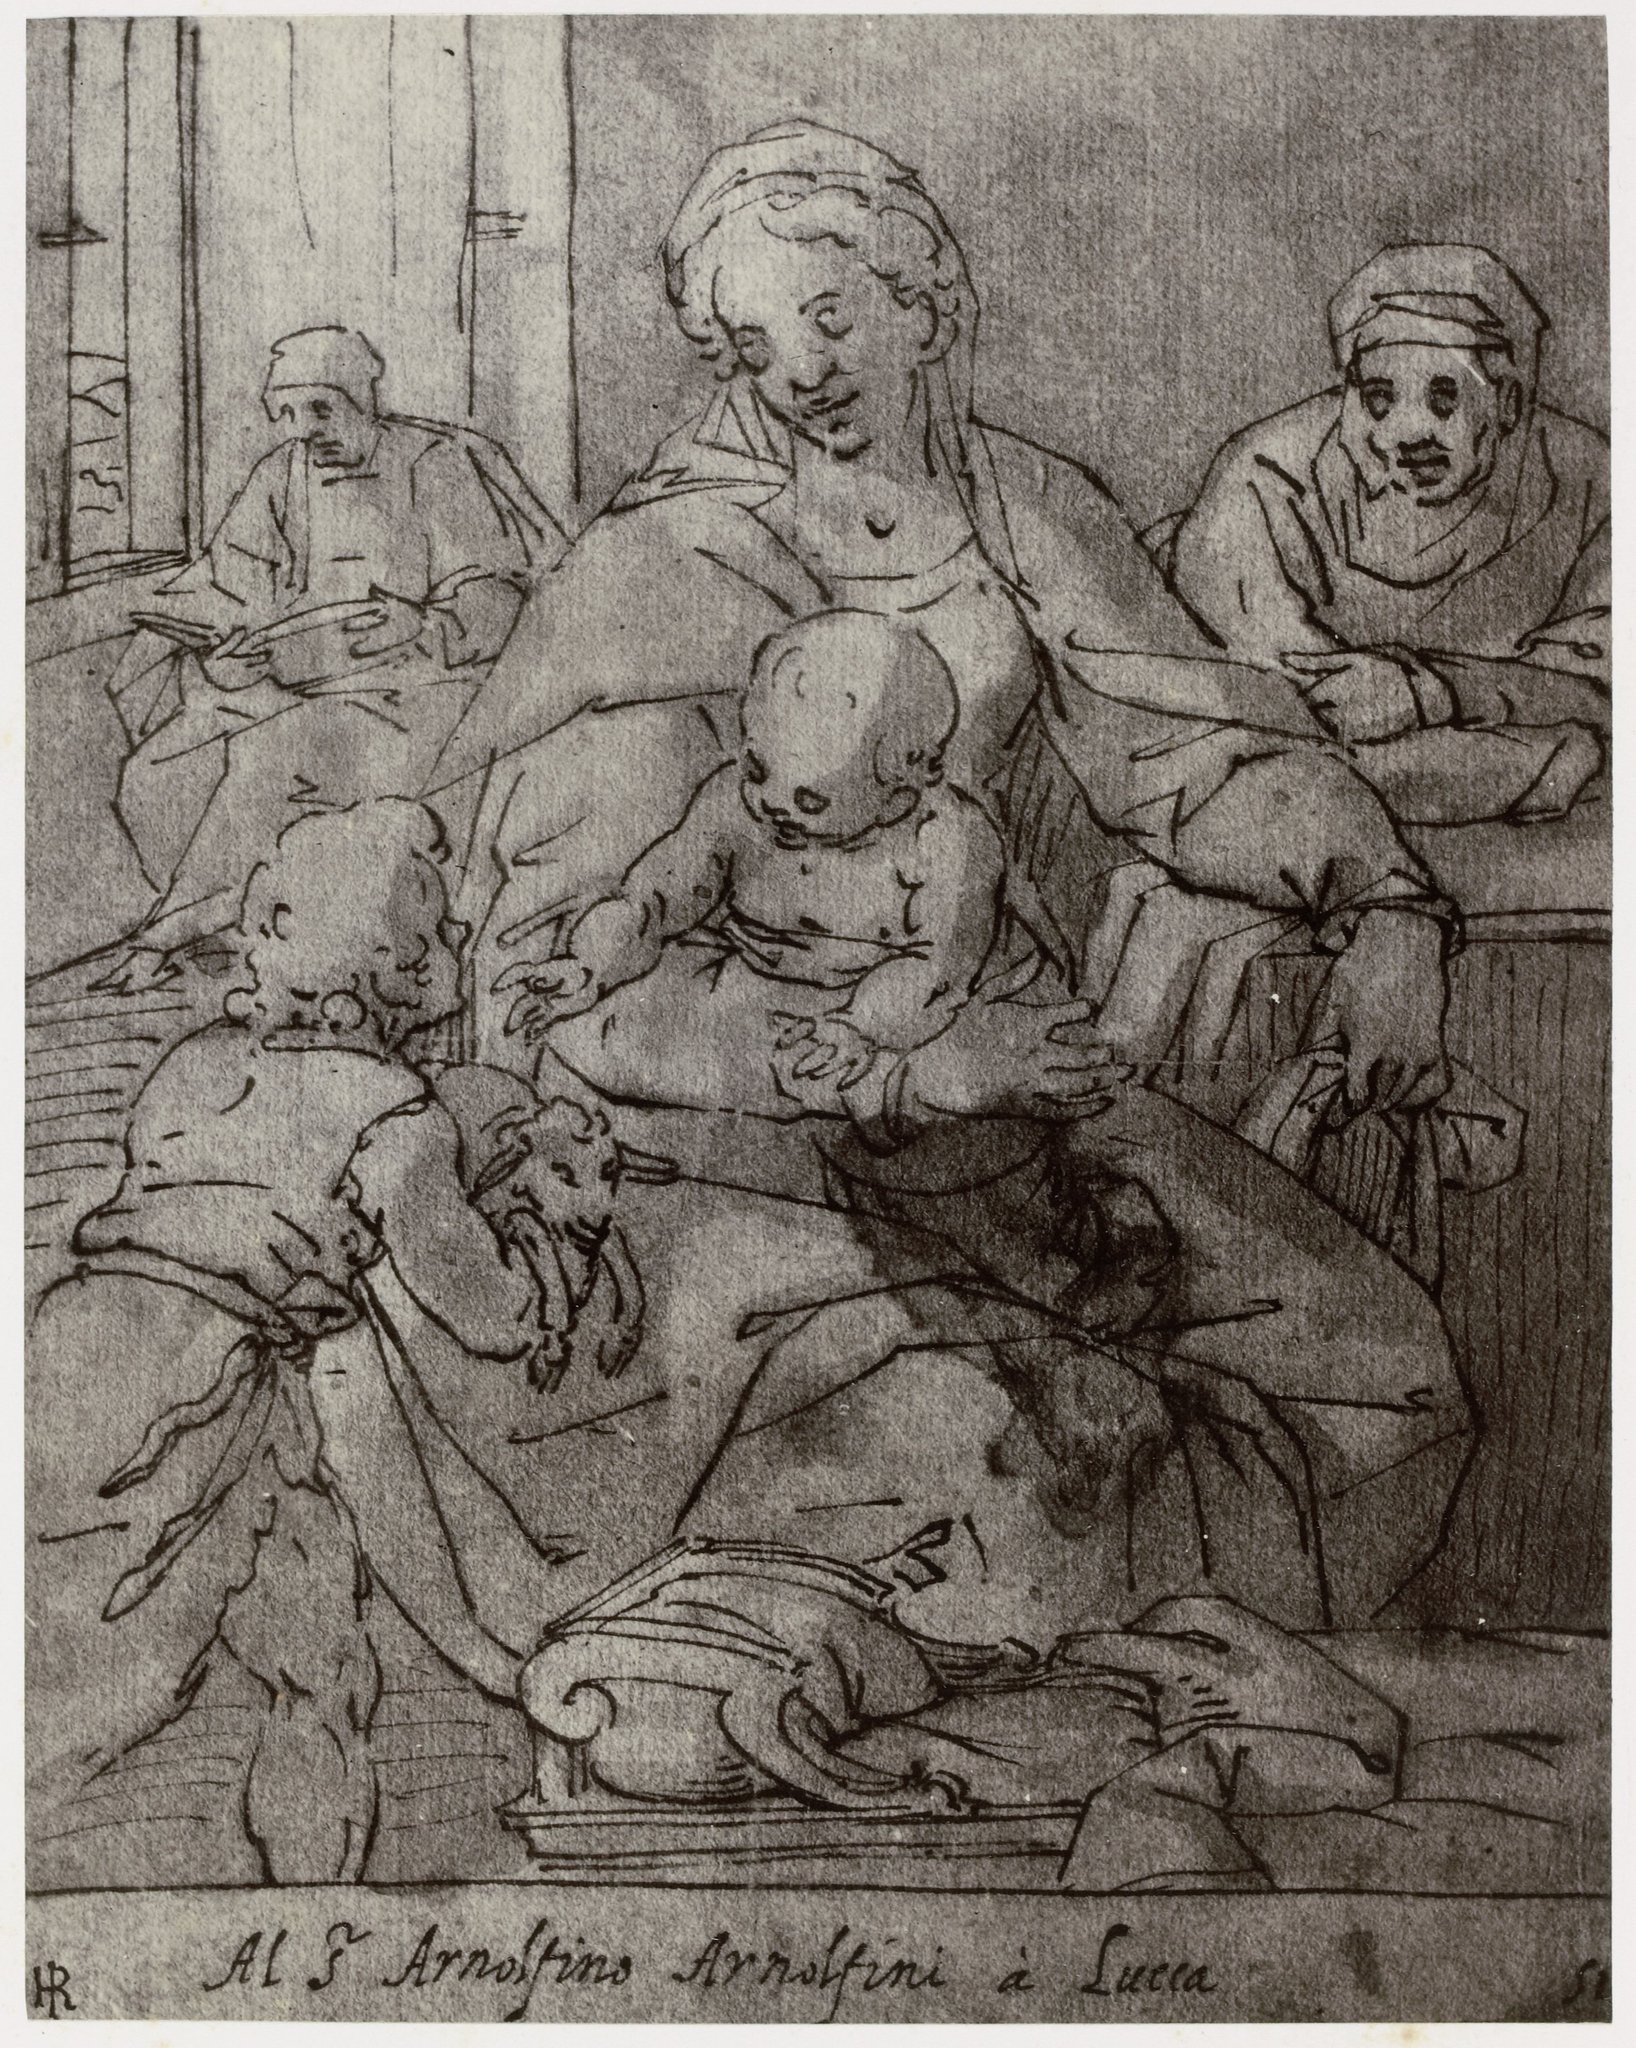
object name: photograph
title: Cangiasi, A Holy Family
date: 1855-1858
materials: cardboard, paper, photographic support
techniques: albumen print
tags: drawing, sketch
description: Fotoreproductie van tekening in 'The Reveley Collection of Drawings at Brynygwin', afb. 4.